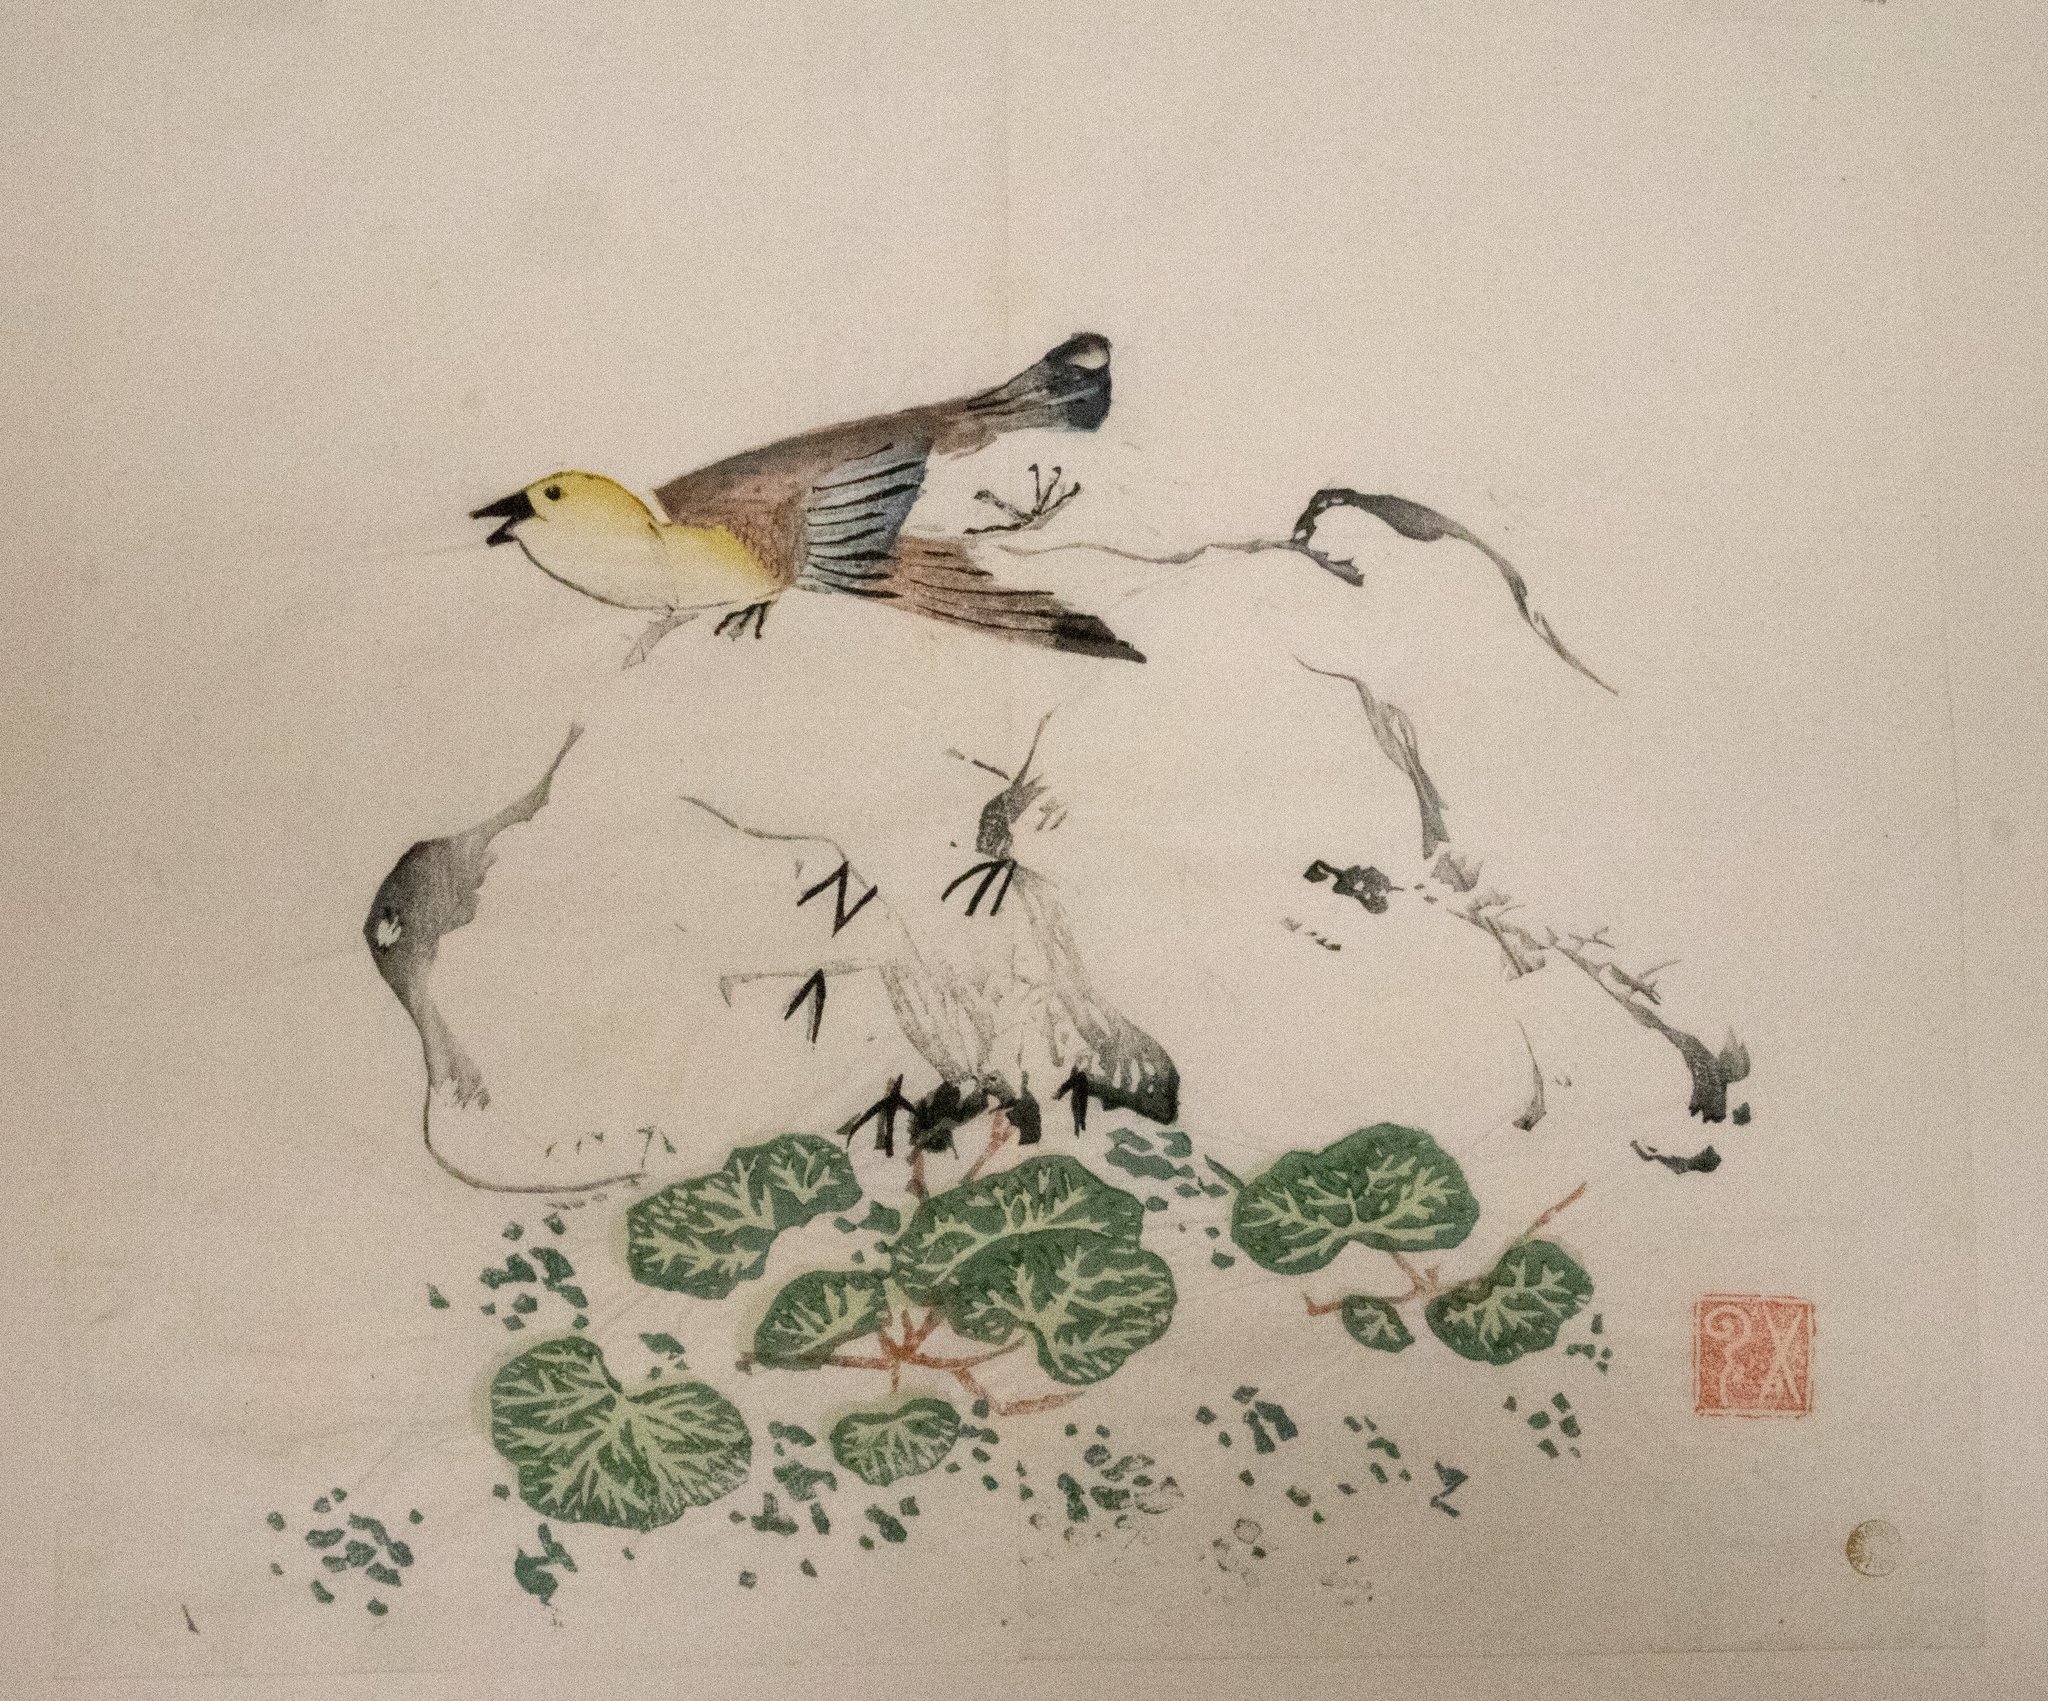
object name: print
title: Page from Shi Zhu Zhai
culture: chinese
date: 1736-1795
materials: ink, paper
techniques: polychrome, woodblock print